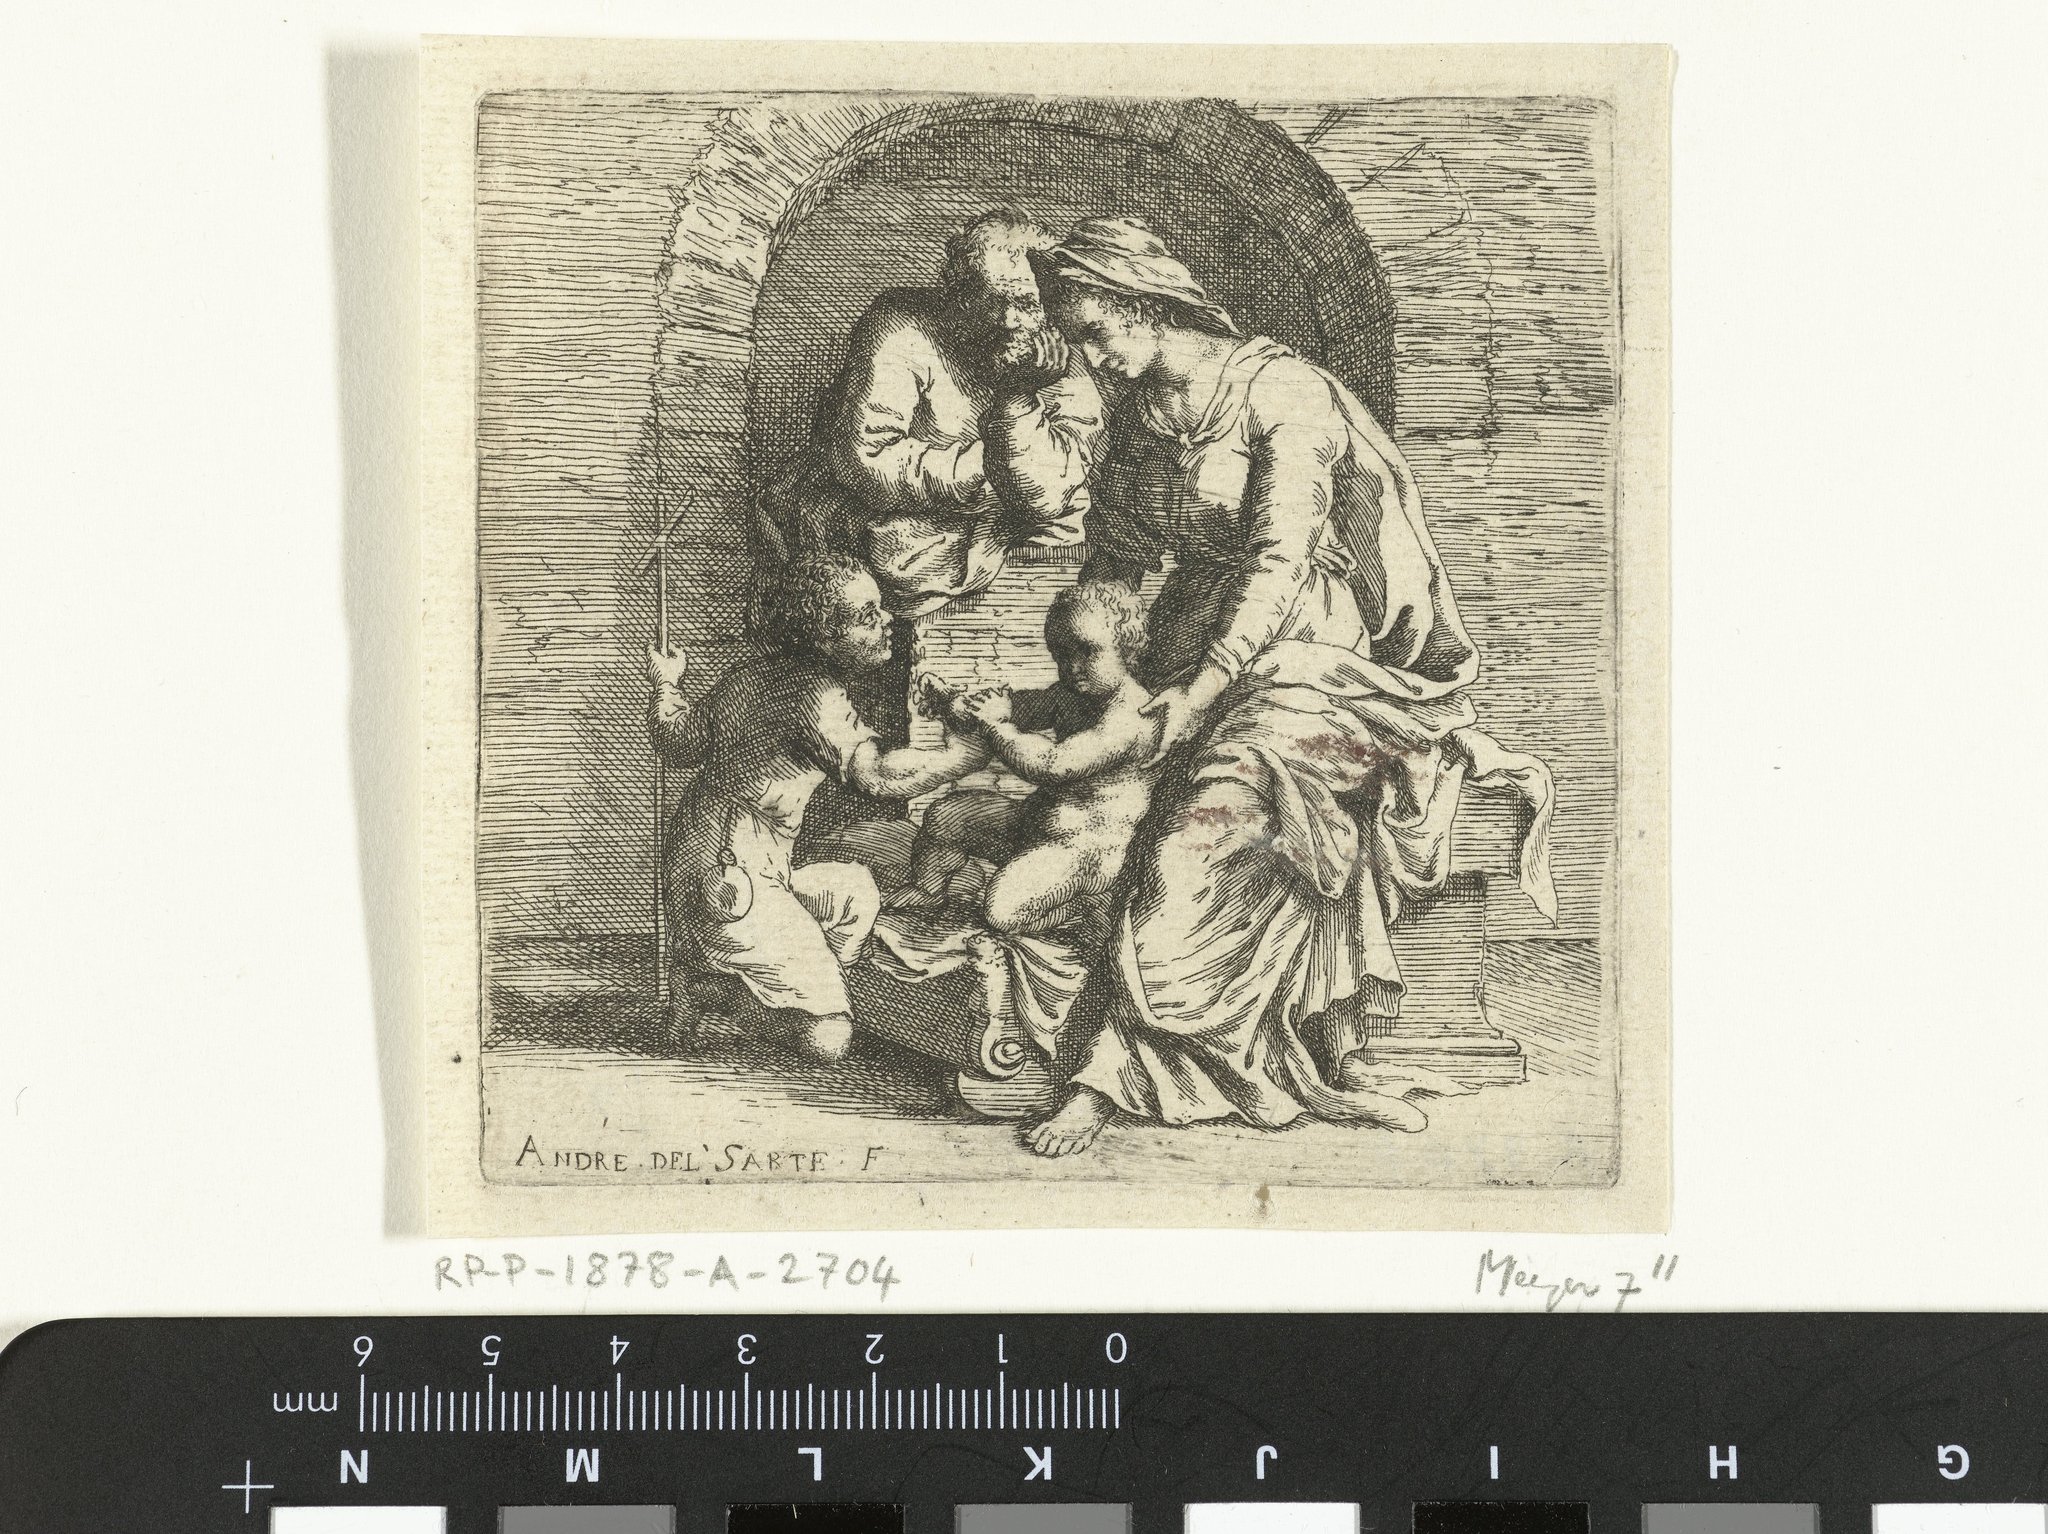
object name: print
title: De heilige familie met Johannes de Doper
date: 1633-1672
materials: paper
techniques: etching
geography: amsterdam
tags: holy family with john the baptist (as child)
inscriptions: collector's mark: Lugt 2228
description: Maria houdt Christus vast, die op een wieg knielt en een vrucht aan neemt die Johannes de Doper hem aanreikt. Joseph staat achter hen.